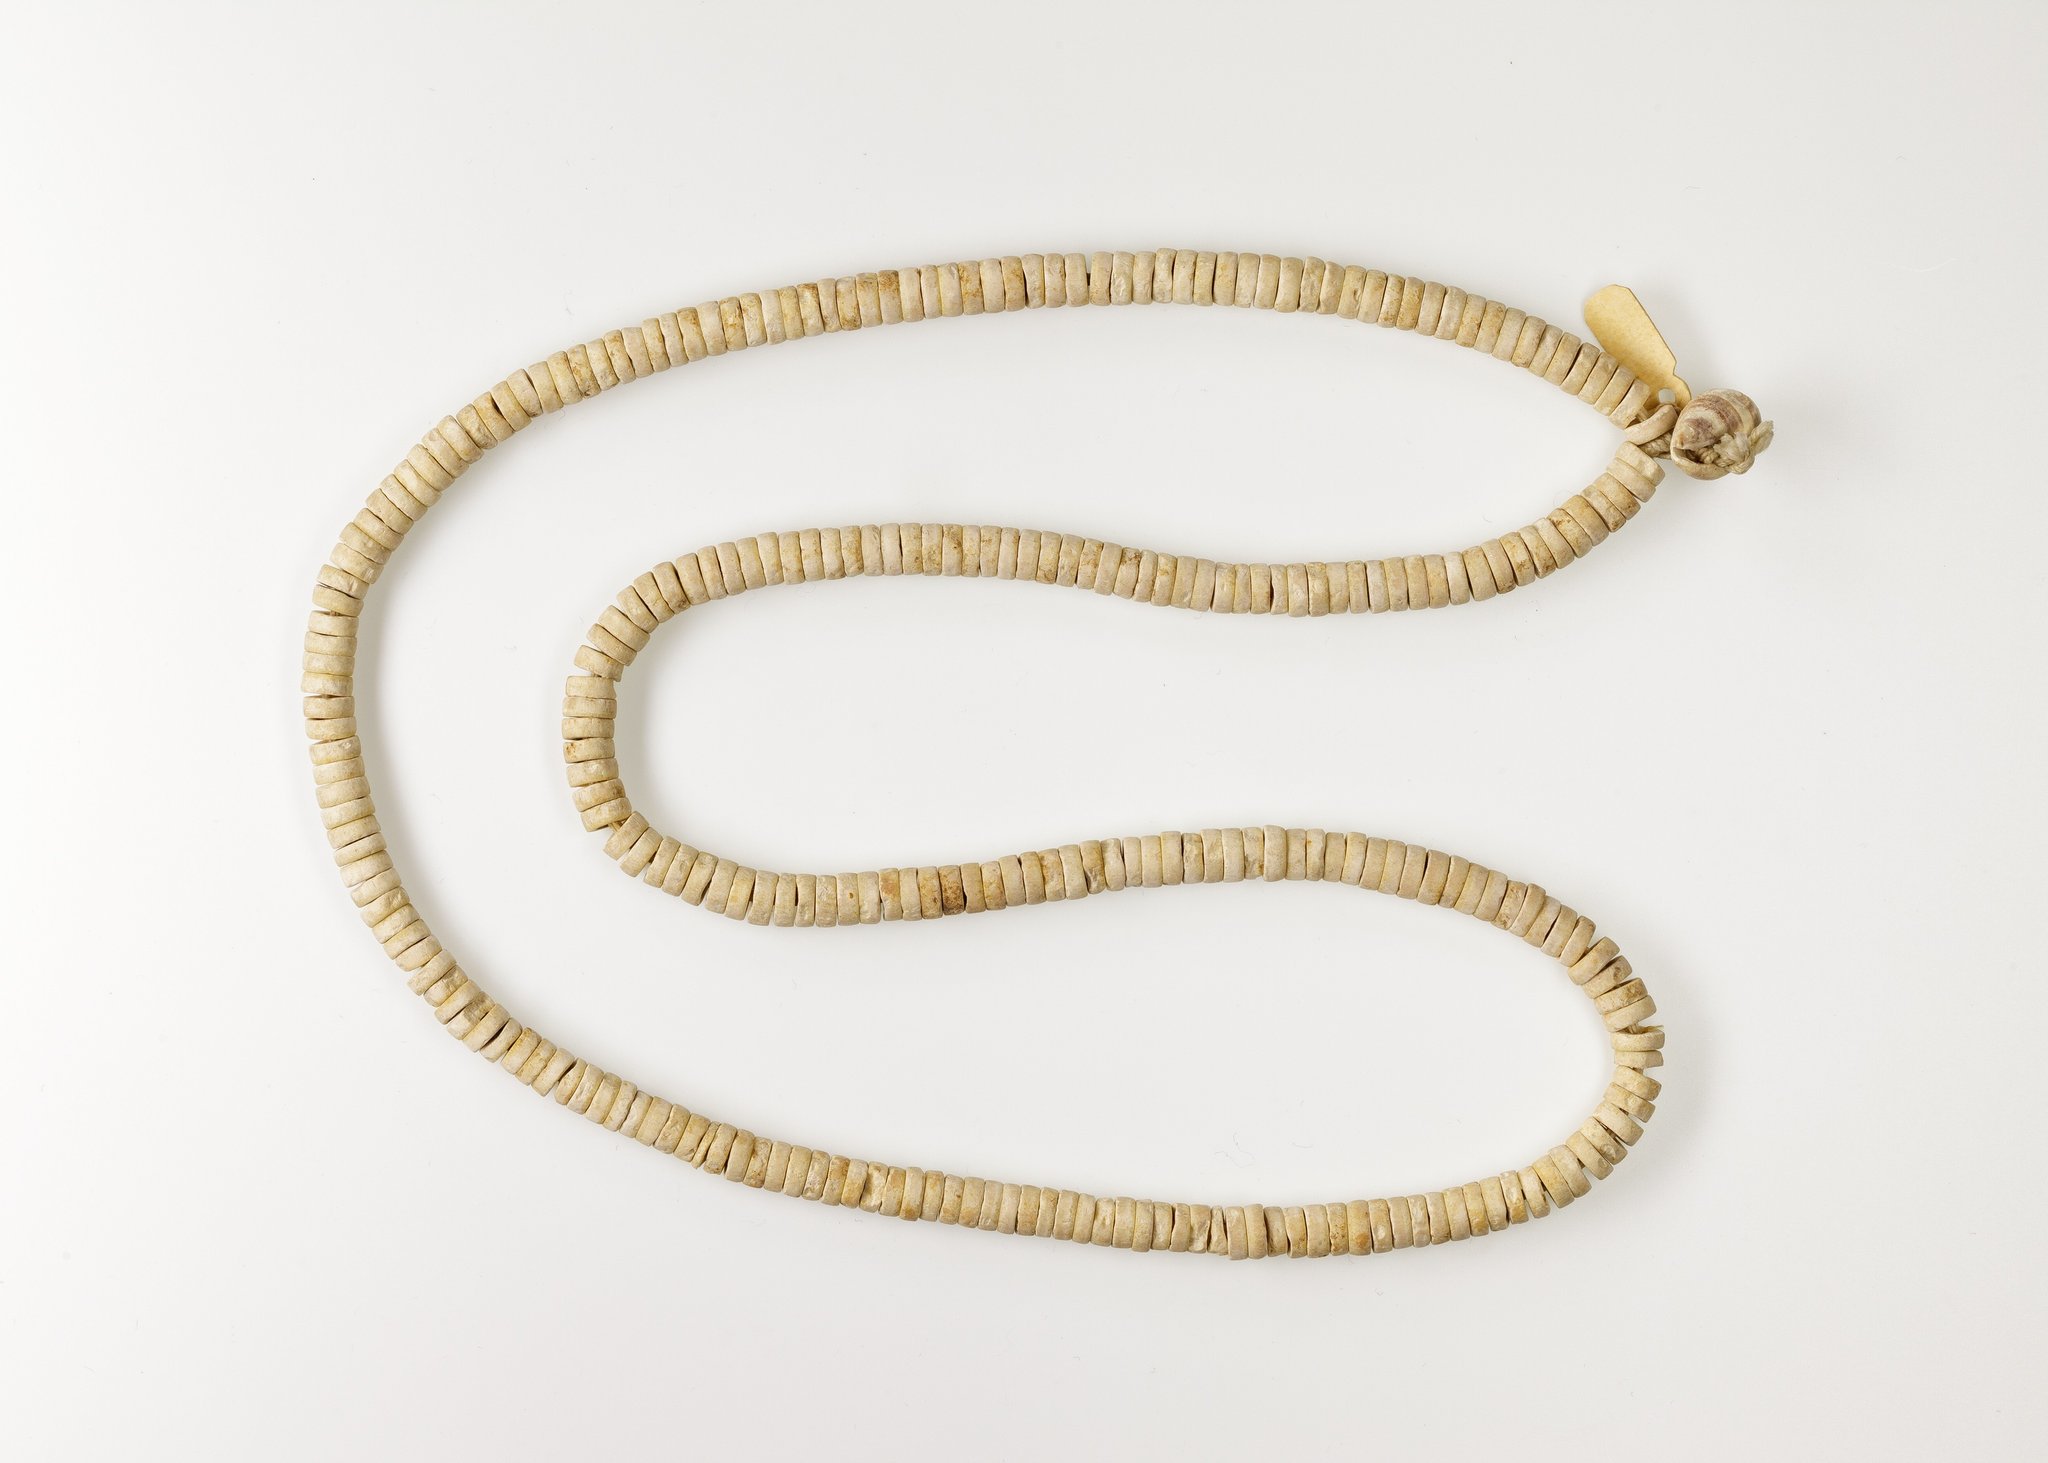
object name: necklace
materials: shell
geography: egypt